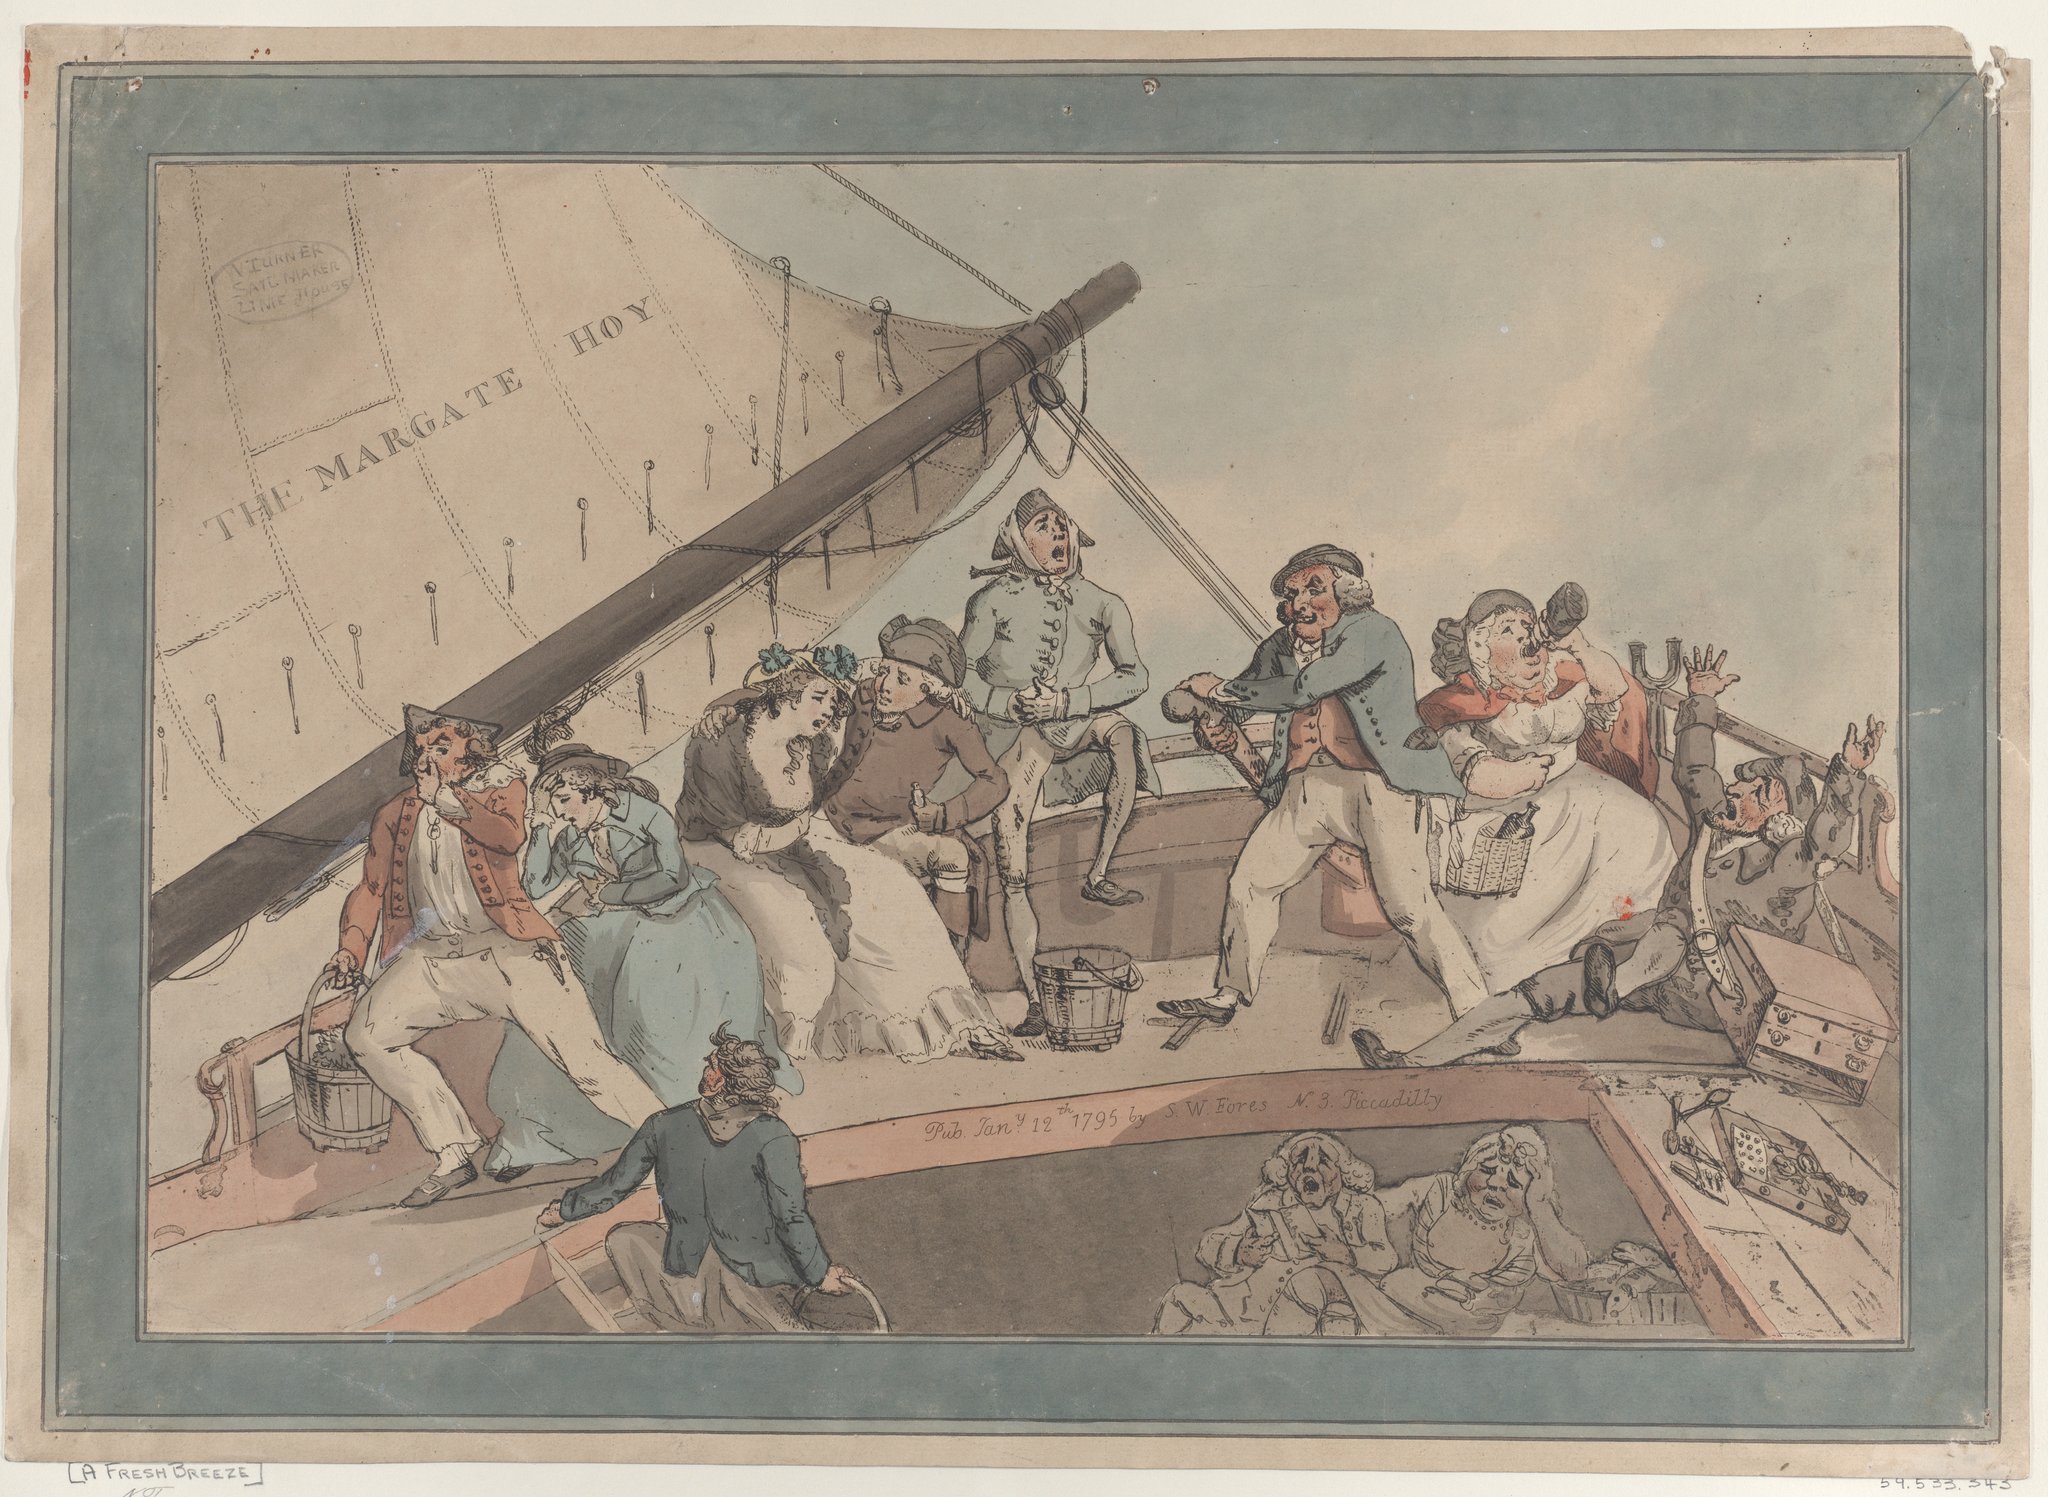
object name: print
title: The Margate Hoy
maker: charles catton, jr.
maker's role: artist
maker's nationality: british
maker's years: 1756-1819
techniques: etching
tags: illness,men,women,boats